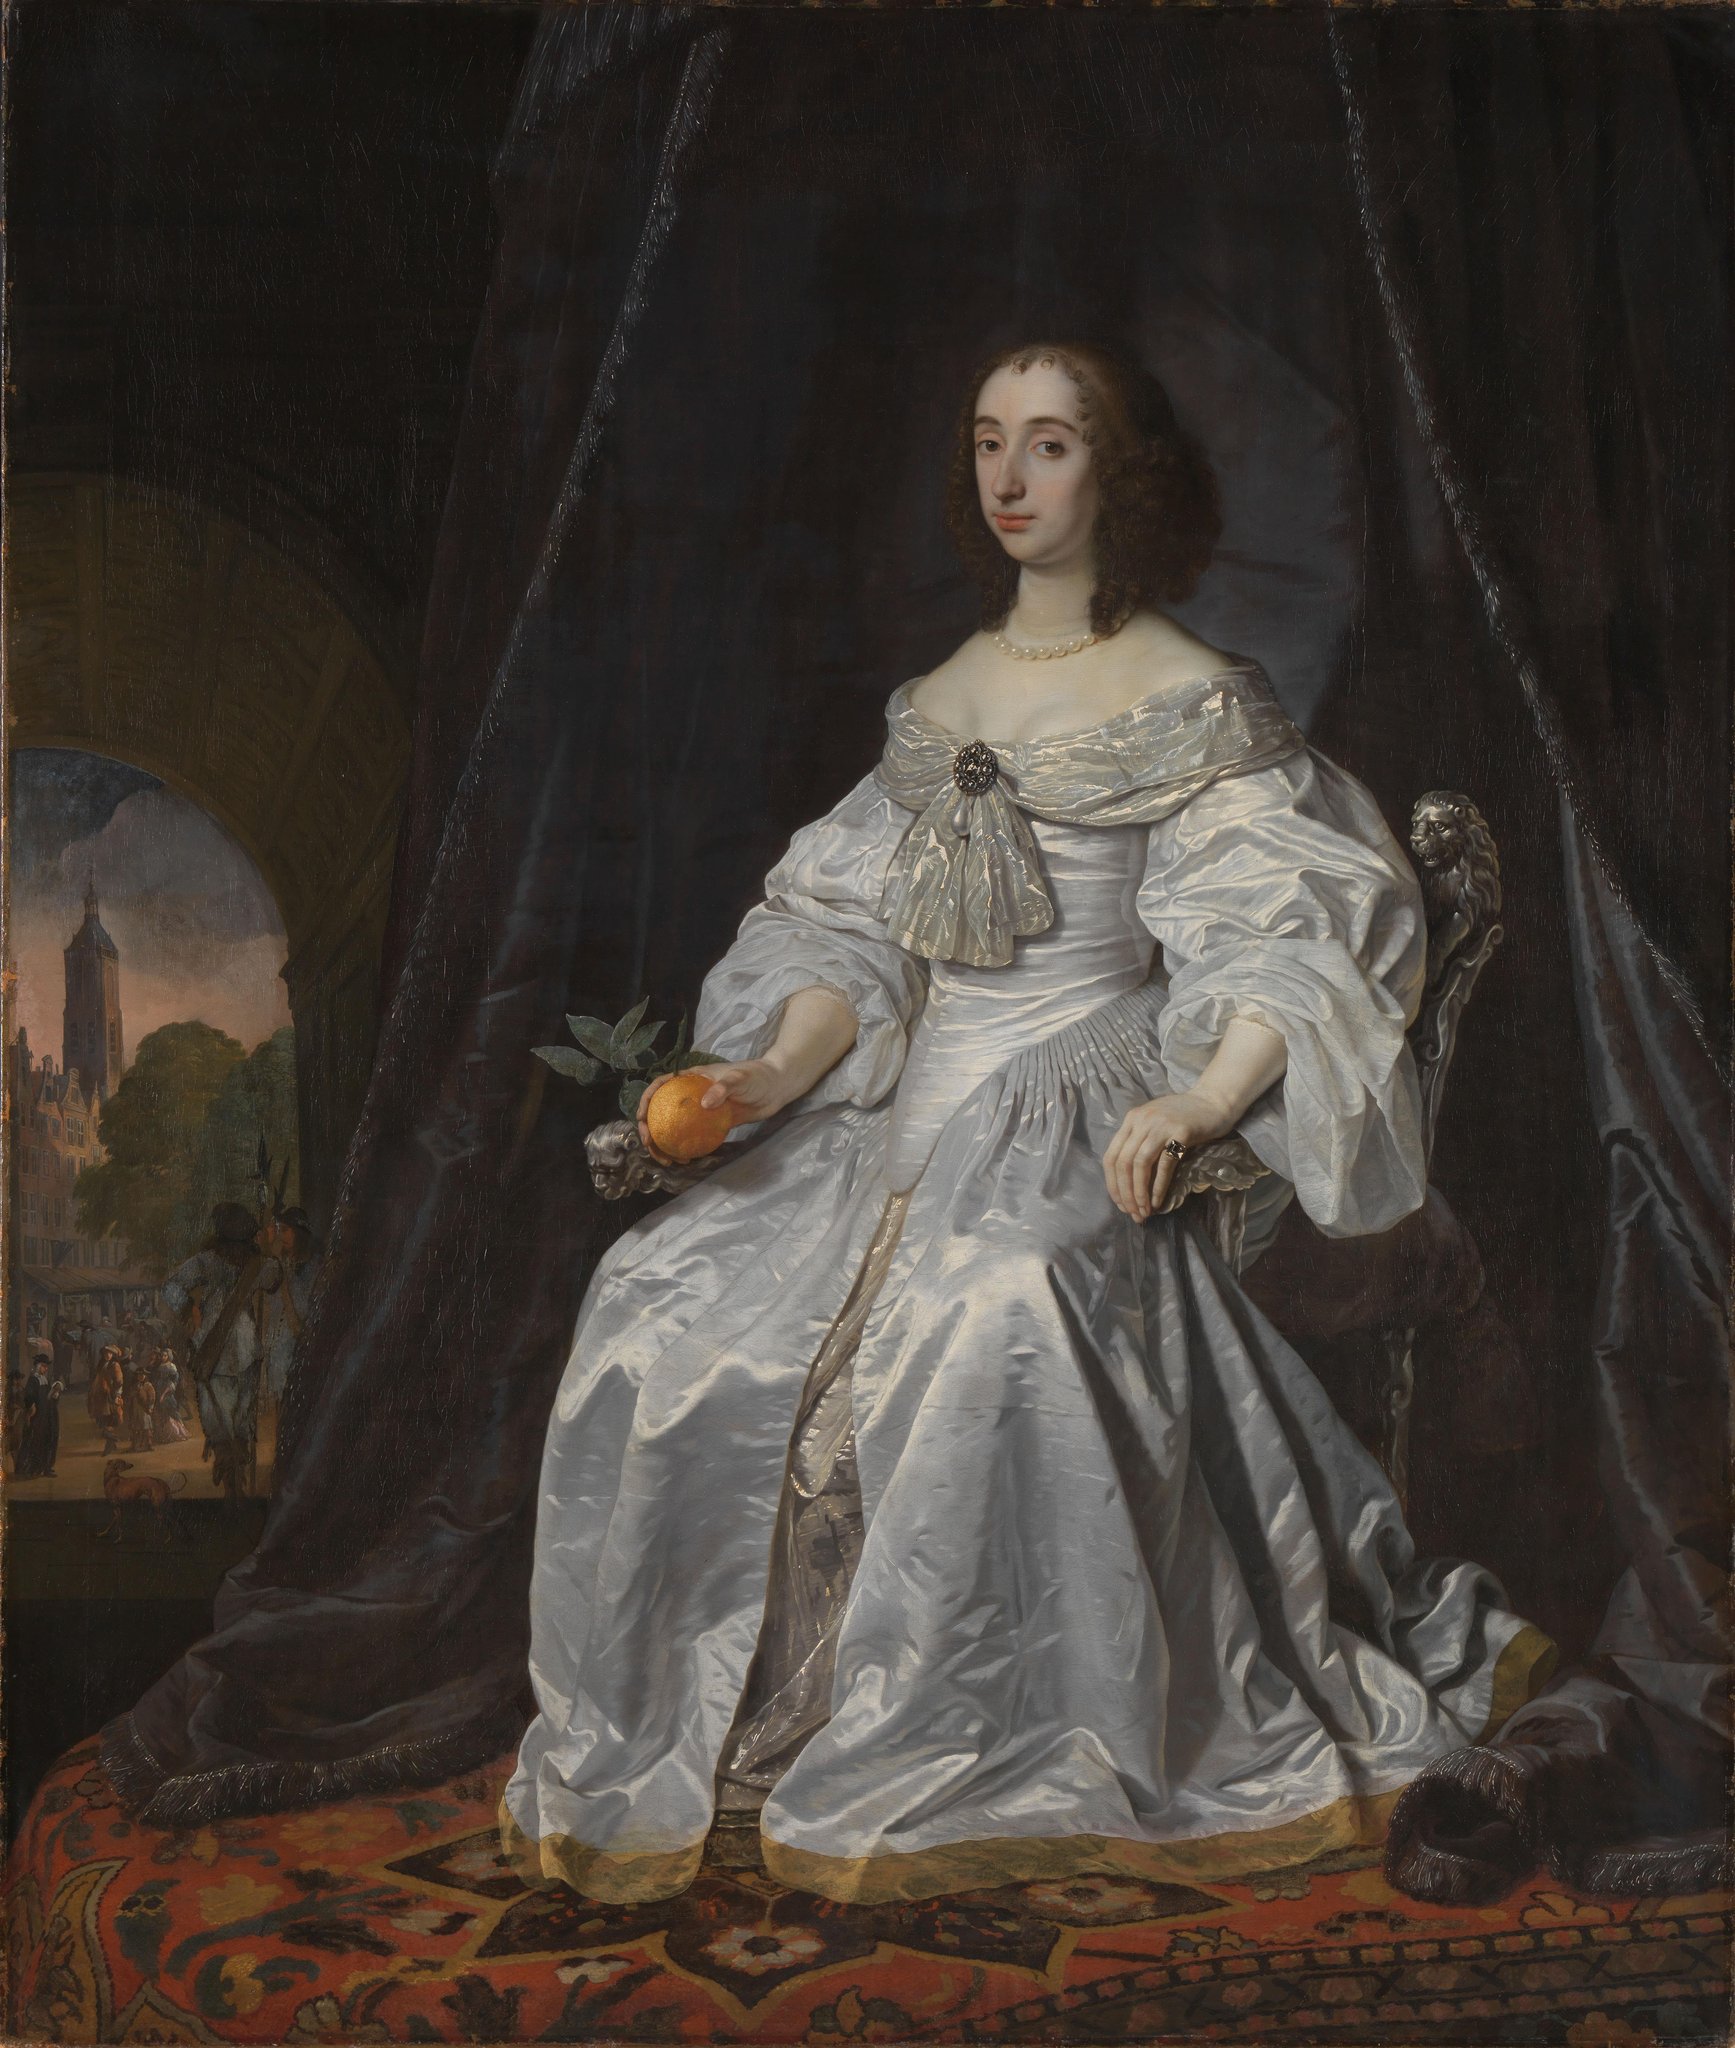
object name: painting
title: Mary Stuart, Princess of Orange, as Widow of William II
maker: bartholomeus van der helst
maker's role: draughtsman, painter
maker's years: 1613-1670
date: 1652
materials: canvas, oil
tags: william ii (prince of orange), london, mary henrietta stuart, historical persons - bb - woman, fruits: orange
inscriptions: signature and date: ‘Bartholomeus van der helst 1652 f.’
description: Princess of Orange Mary Stuart I is dressed in white, the traditional colour of mourning for a noble. Her husband, Stadholder William II, had died two years earlier. Mary was keen to secure the succession of her very young son. This portrait alludes to that claim to stadtholdership: she holds an orange, symbolizing the House of Orange. At the left is depicted the Stadtholders’ Gate of the Binnenhof (Inner Court) in The Hague.